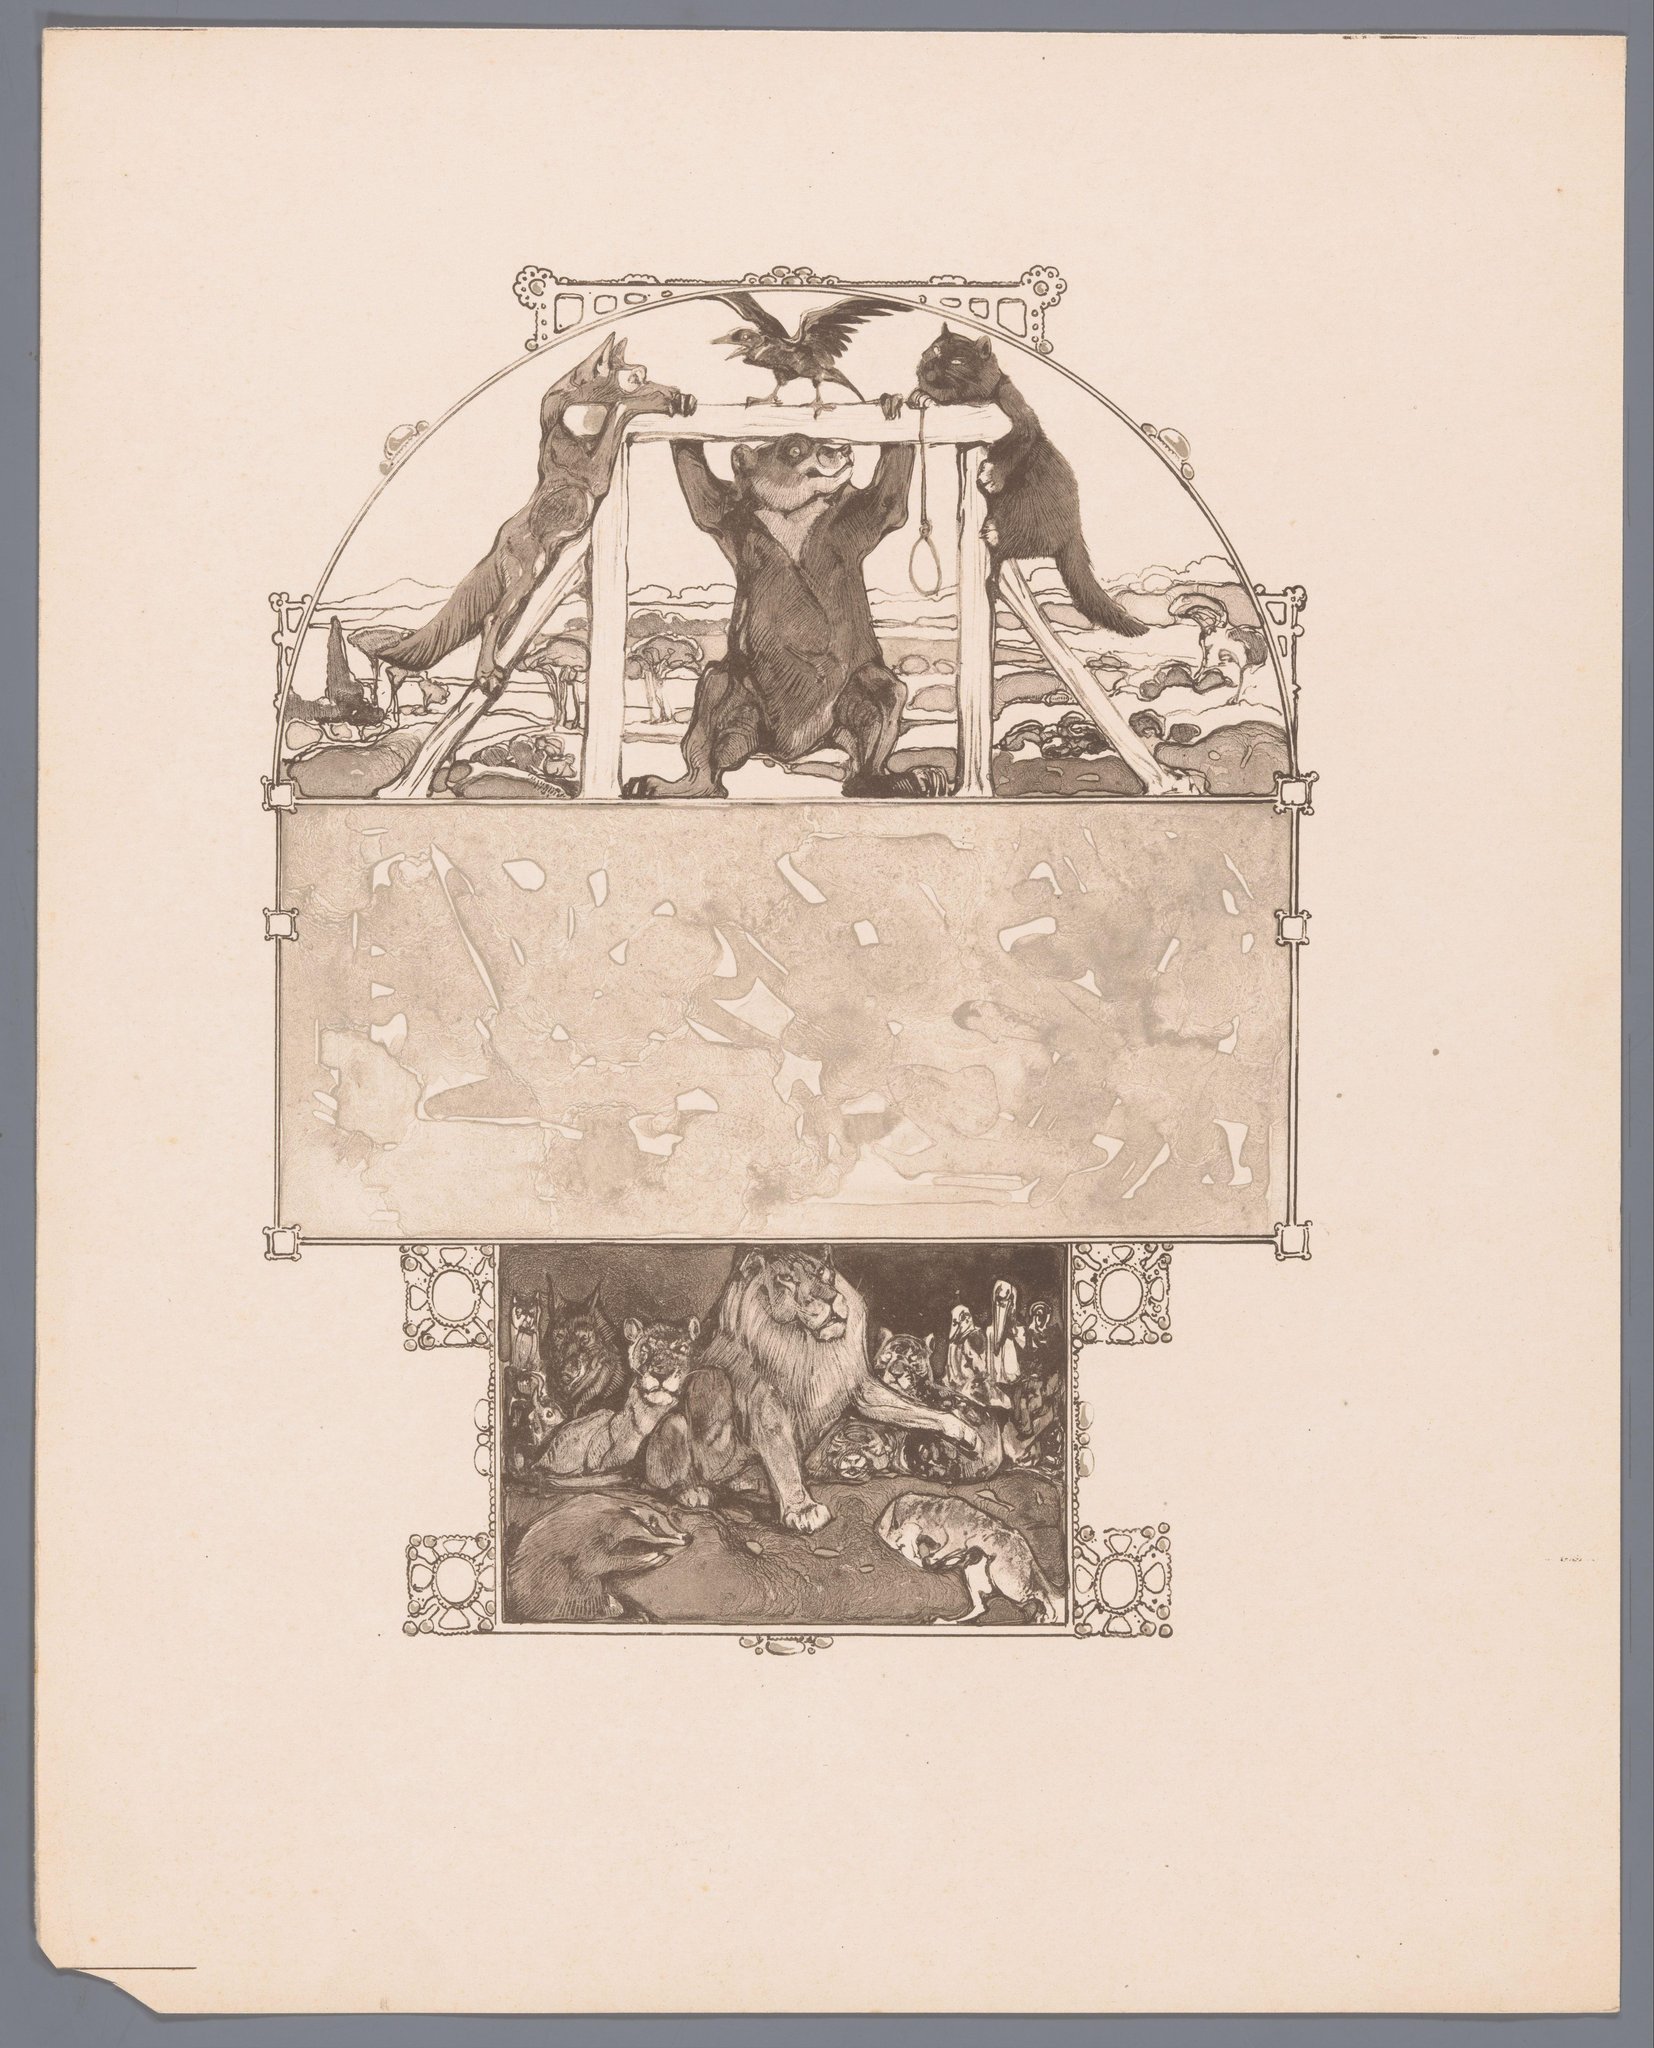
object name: boekillustratie ontwerp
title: Vos (Reinaert), beer (Bruun), kat (Tybeert) en raaf (Tiecelijn) bij galg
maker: bernard willem wierink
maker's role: draughtsman, print maker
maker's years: 1856-1939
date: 1910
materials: paper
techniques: lithograph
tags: fable of reynard the fox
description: Ontwerp voor: Streuvels, Stijn (Frank Lateur). Reinaert de Vos naar verschillende uitgaven van het middeleeuwsche epos. Amsterdam: L.J. Veen, 1910.